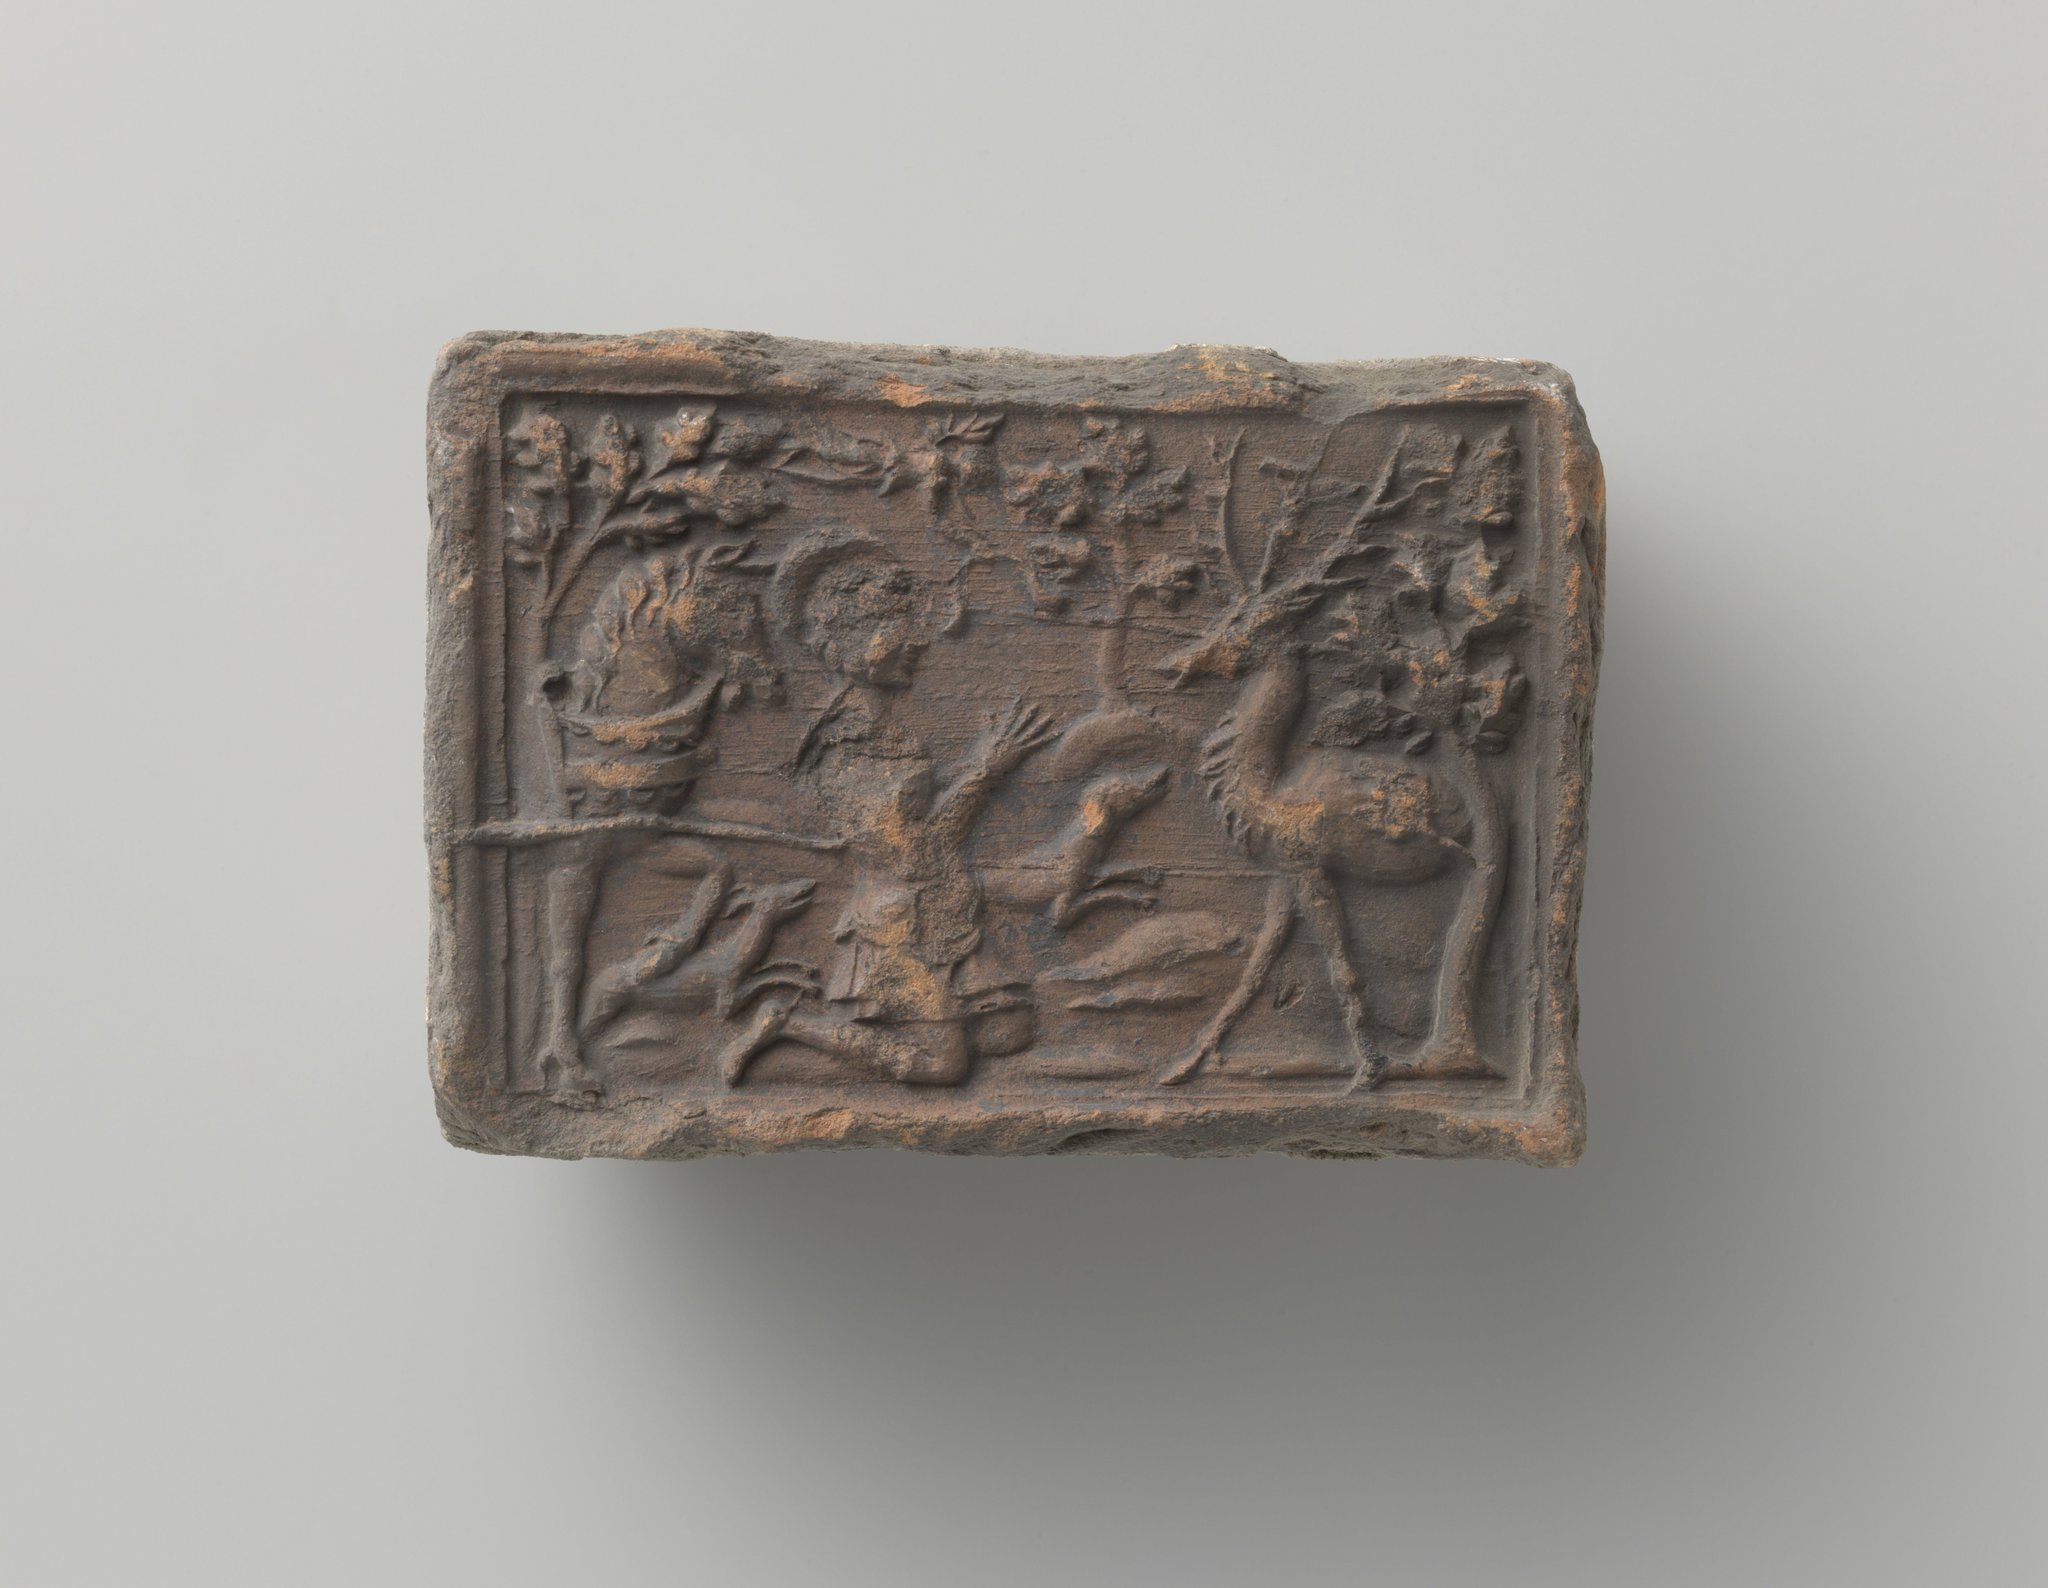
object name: hearthstone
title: Haardsteenmeet voorstelling van sint Hubertus en het hert met het kruis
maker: Anonymous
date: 1525-1575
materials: earthenware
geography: southern netherlands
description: Haardsteen met voorstelling van Sint Hubertus, geknield voor het hert met het kruis tussen het gewei, en vergezeld van paard en honden. Op de achtergrond een heuvelachtig landschap met bomen.